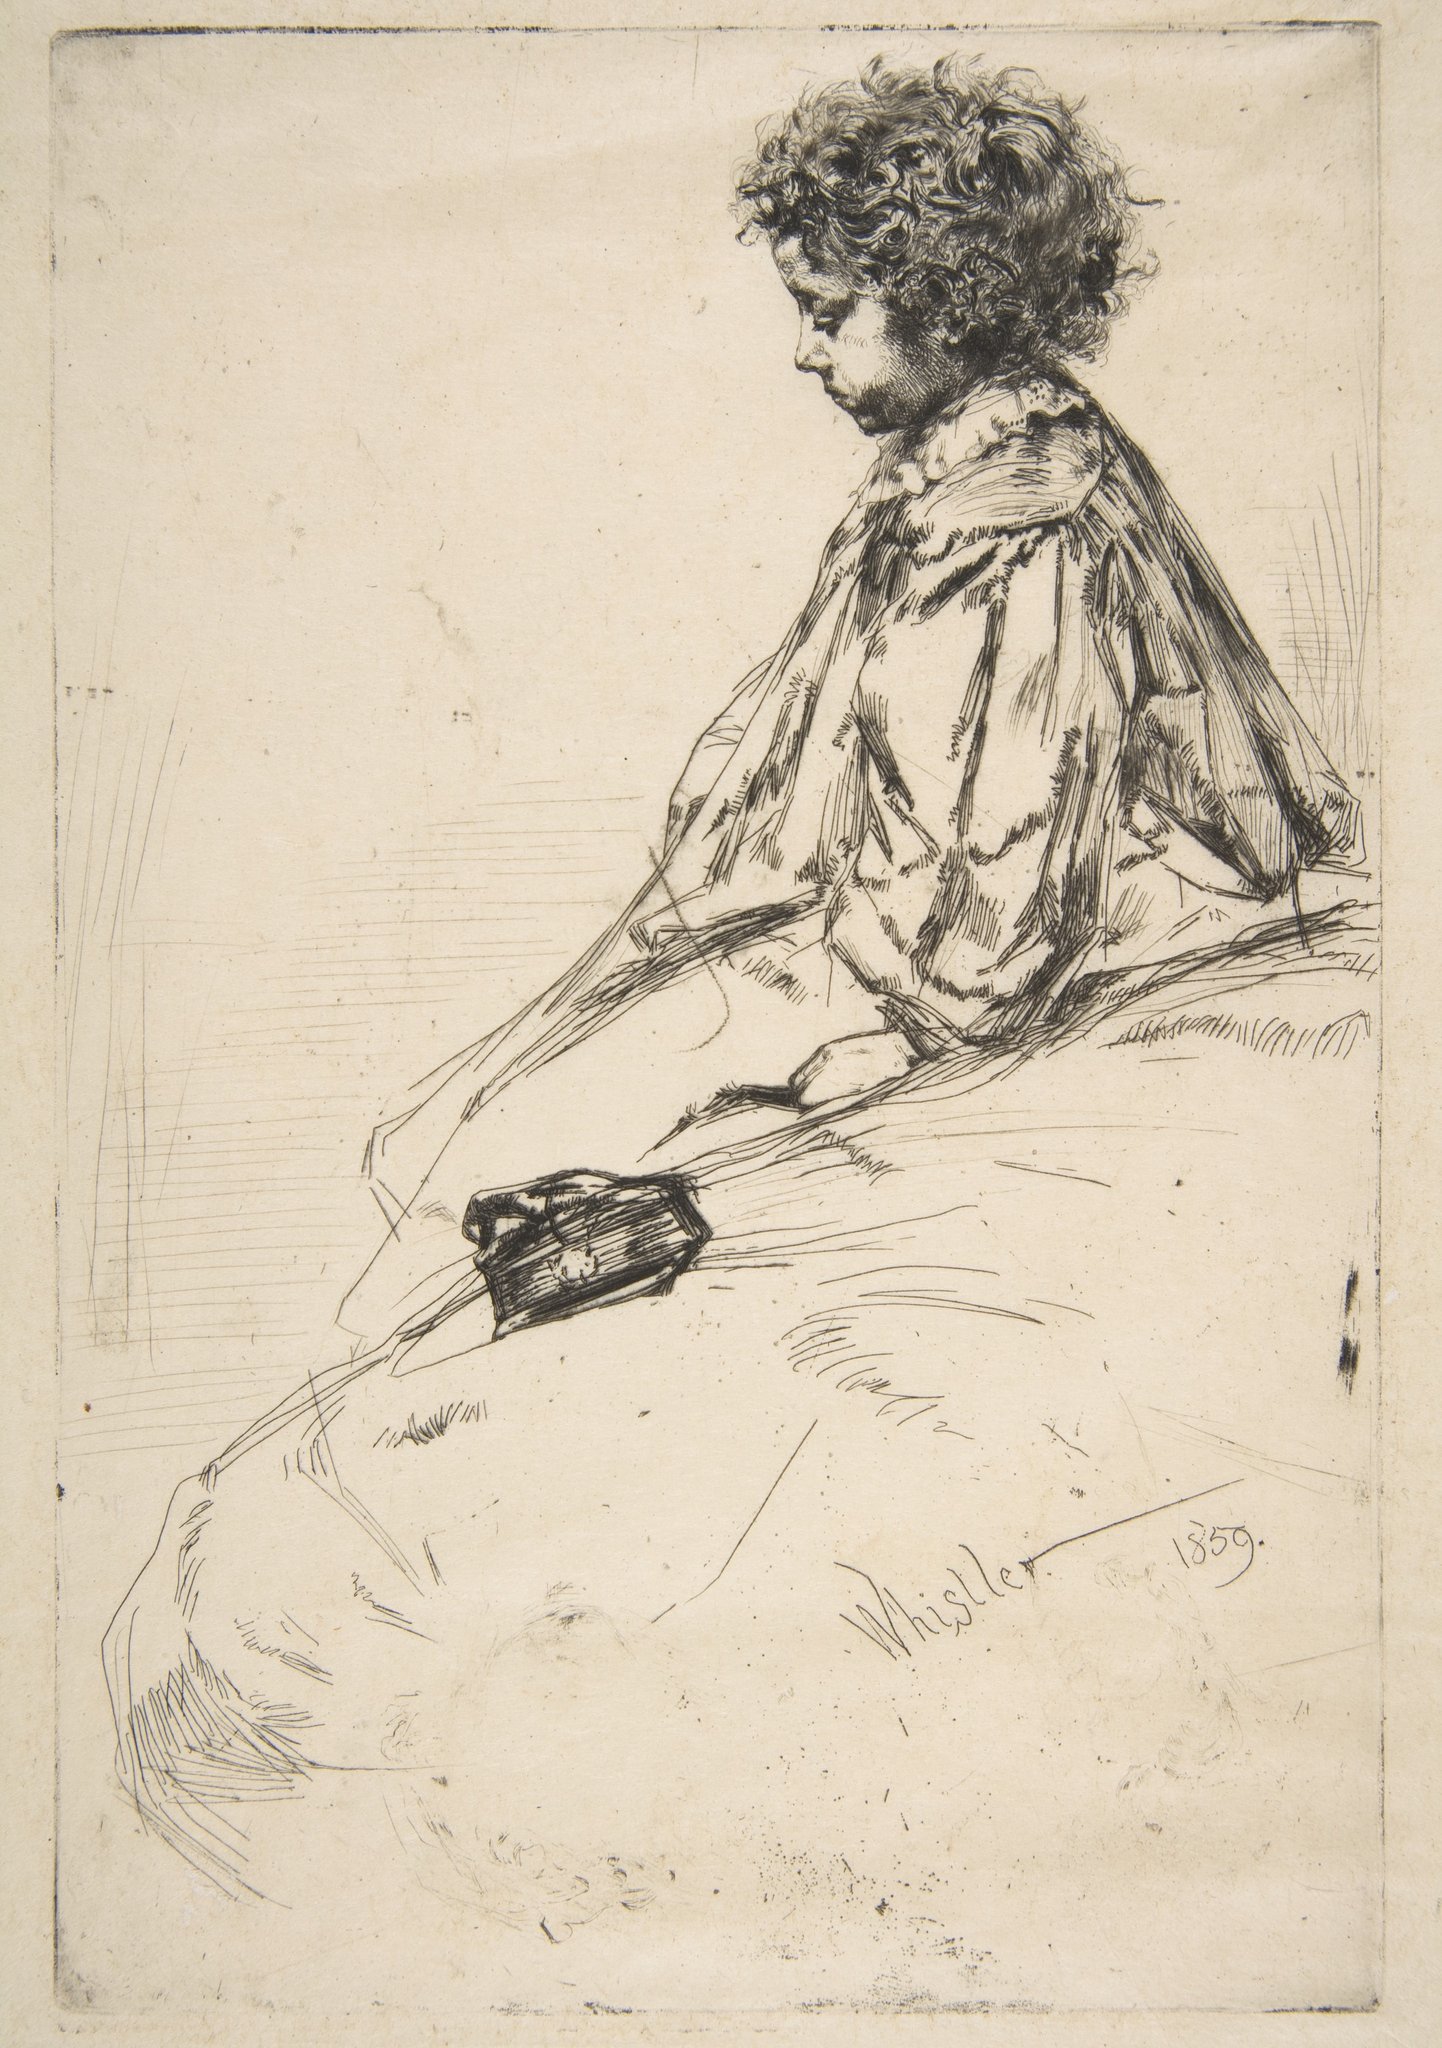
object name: print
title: Bibi Lalouette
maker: james mcneill whistler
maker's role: artist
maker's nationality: american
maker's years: 1834-1903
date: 1859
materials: ink, ivory, paper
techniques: drypoint, etching, printing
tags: girls